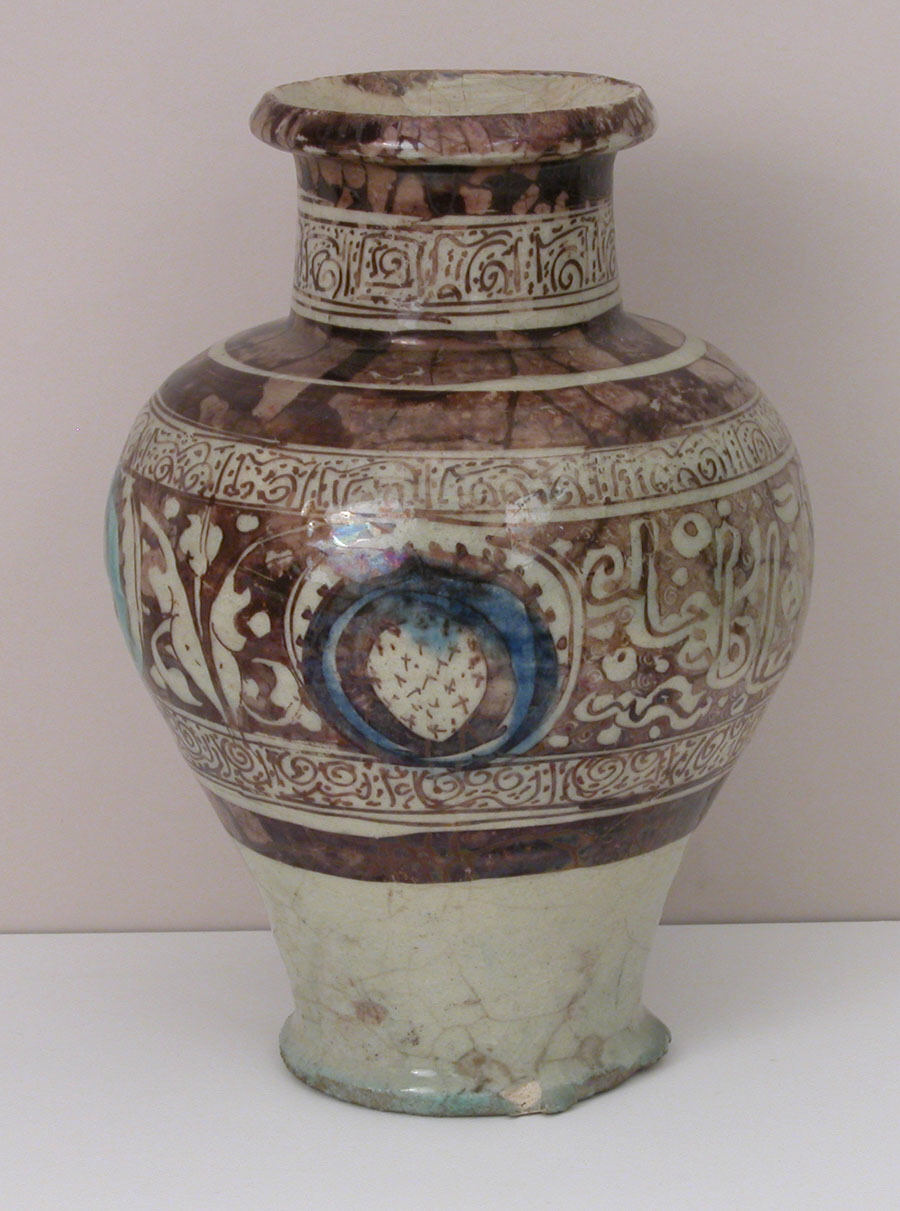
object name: vase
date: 1101-1200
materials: glaze, stonepaste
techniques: painting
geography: syria